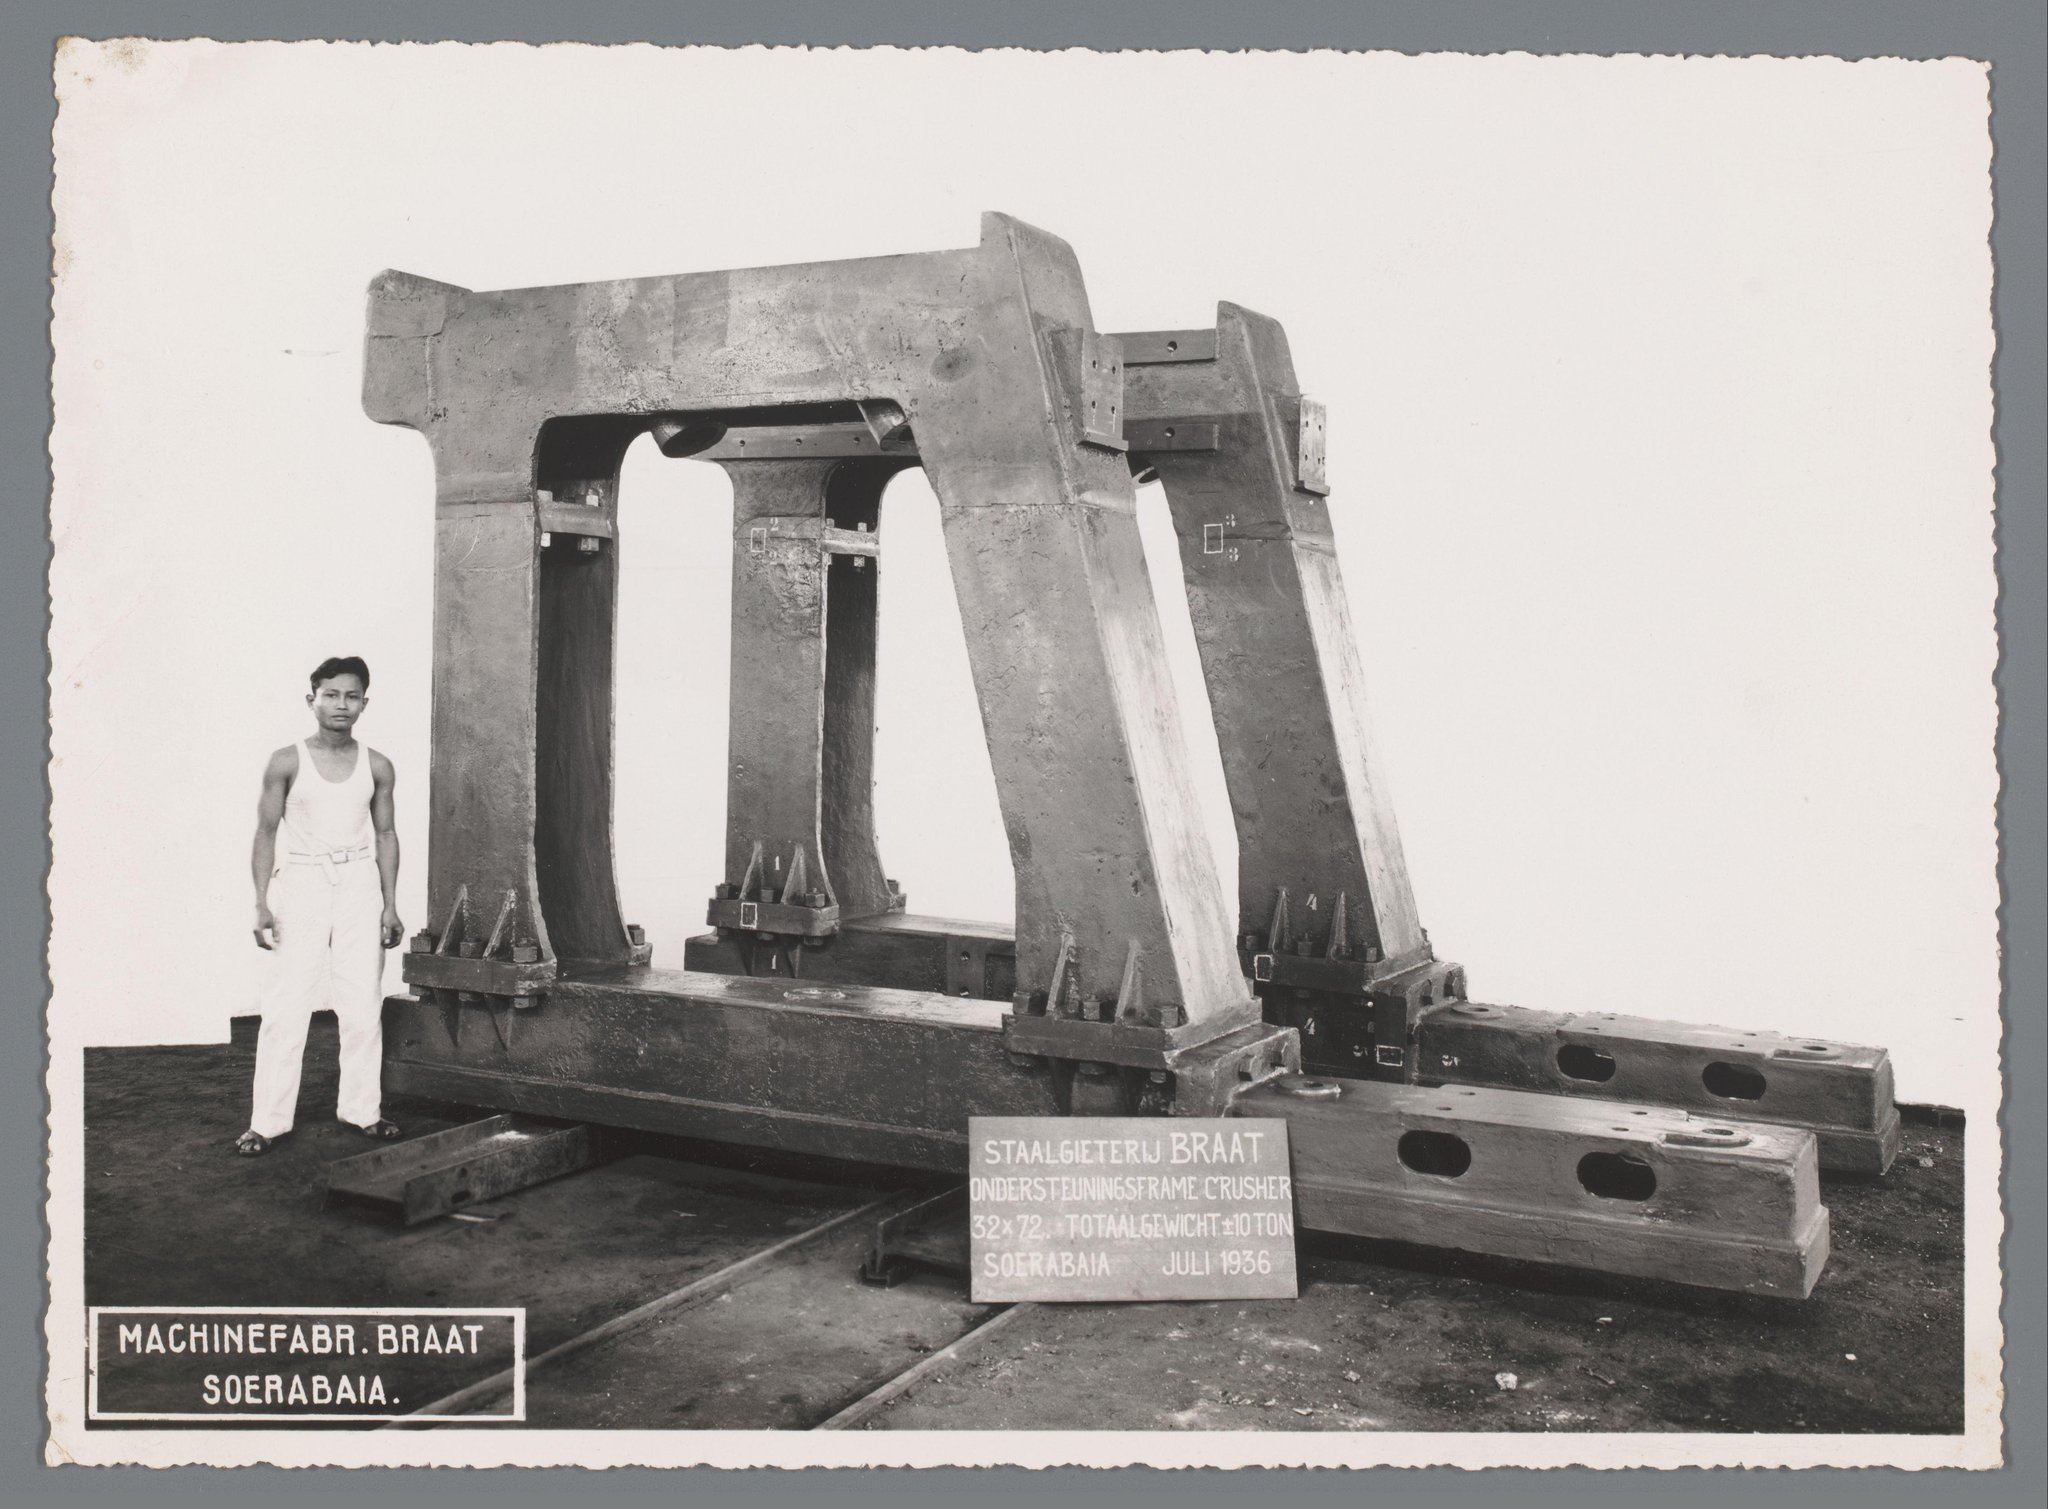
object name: photograph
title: Ondersteuningsframe voor de crusher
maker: Anonymous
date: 1907-1936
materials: photographic support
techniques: gelatin silver print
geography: surabaya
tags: colonial system, machines; parts of machines; tools and appliances, factory-interior, machine shop (+ labourers ~ crafts, industries, agriculture), (non-fruit) products of plants or trees: sugarcane, java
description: Ondersteuningsframe voor de crusher voor een canecutterinstallatie, vervaardigd in 1936 voor de Suikerfabriek Ketanggoengan-West, ten zuidwesten van Brebes. Onderdeel van de multomap met foto's van machines van de N.V. Machinefabriek Braat te Soerabaja bestemd voor de Nederlandse suikerindustrie op Java, uit de periode 1917-1938.